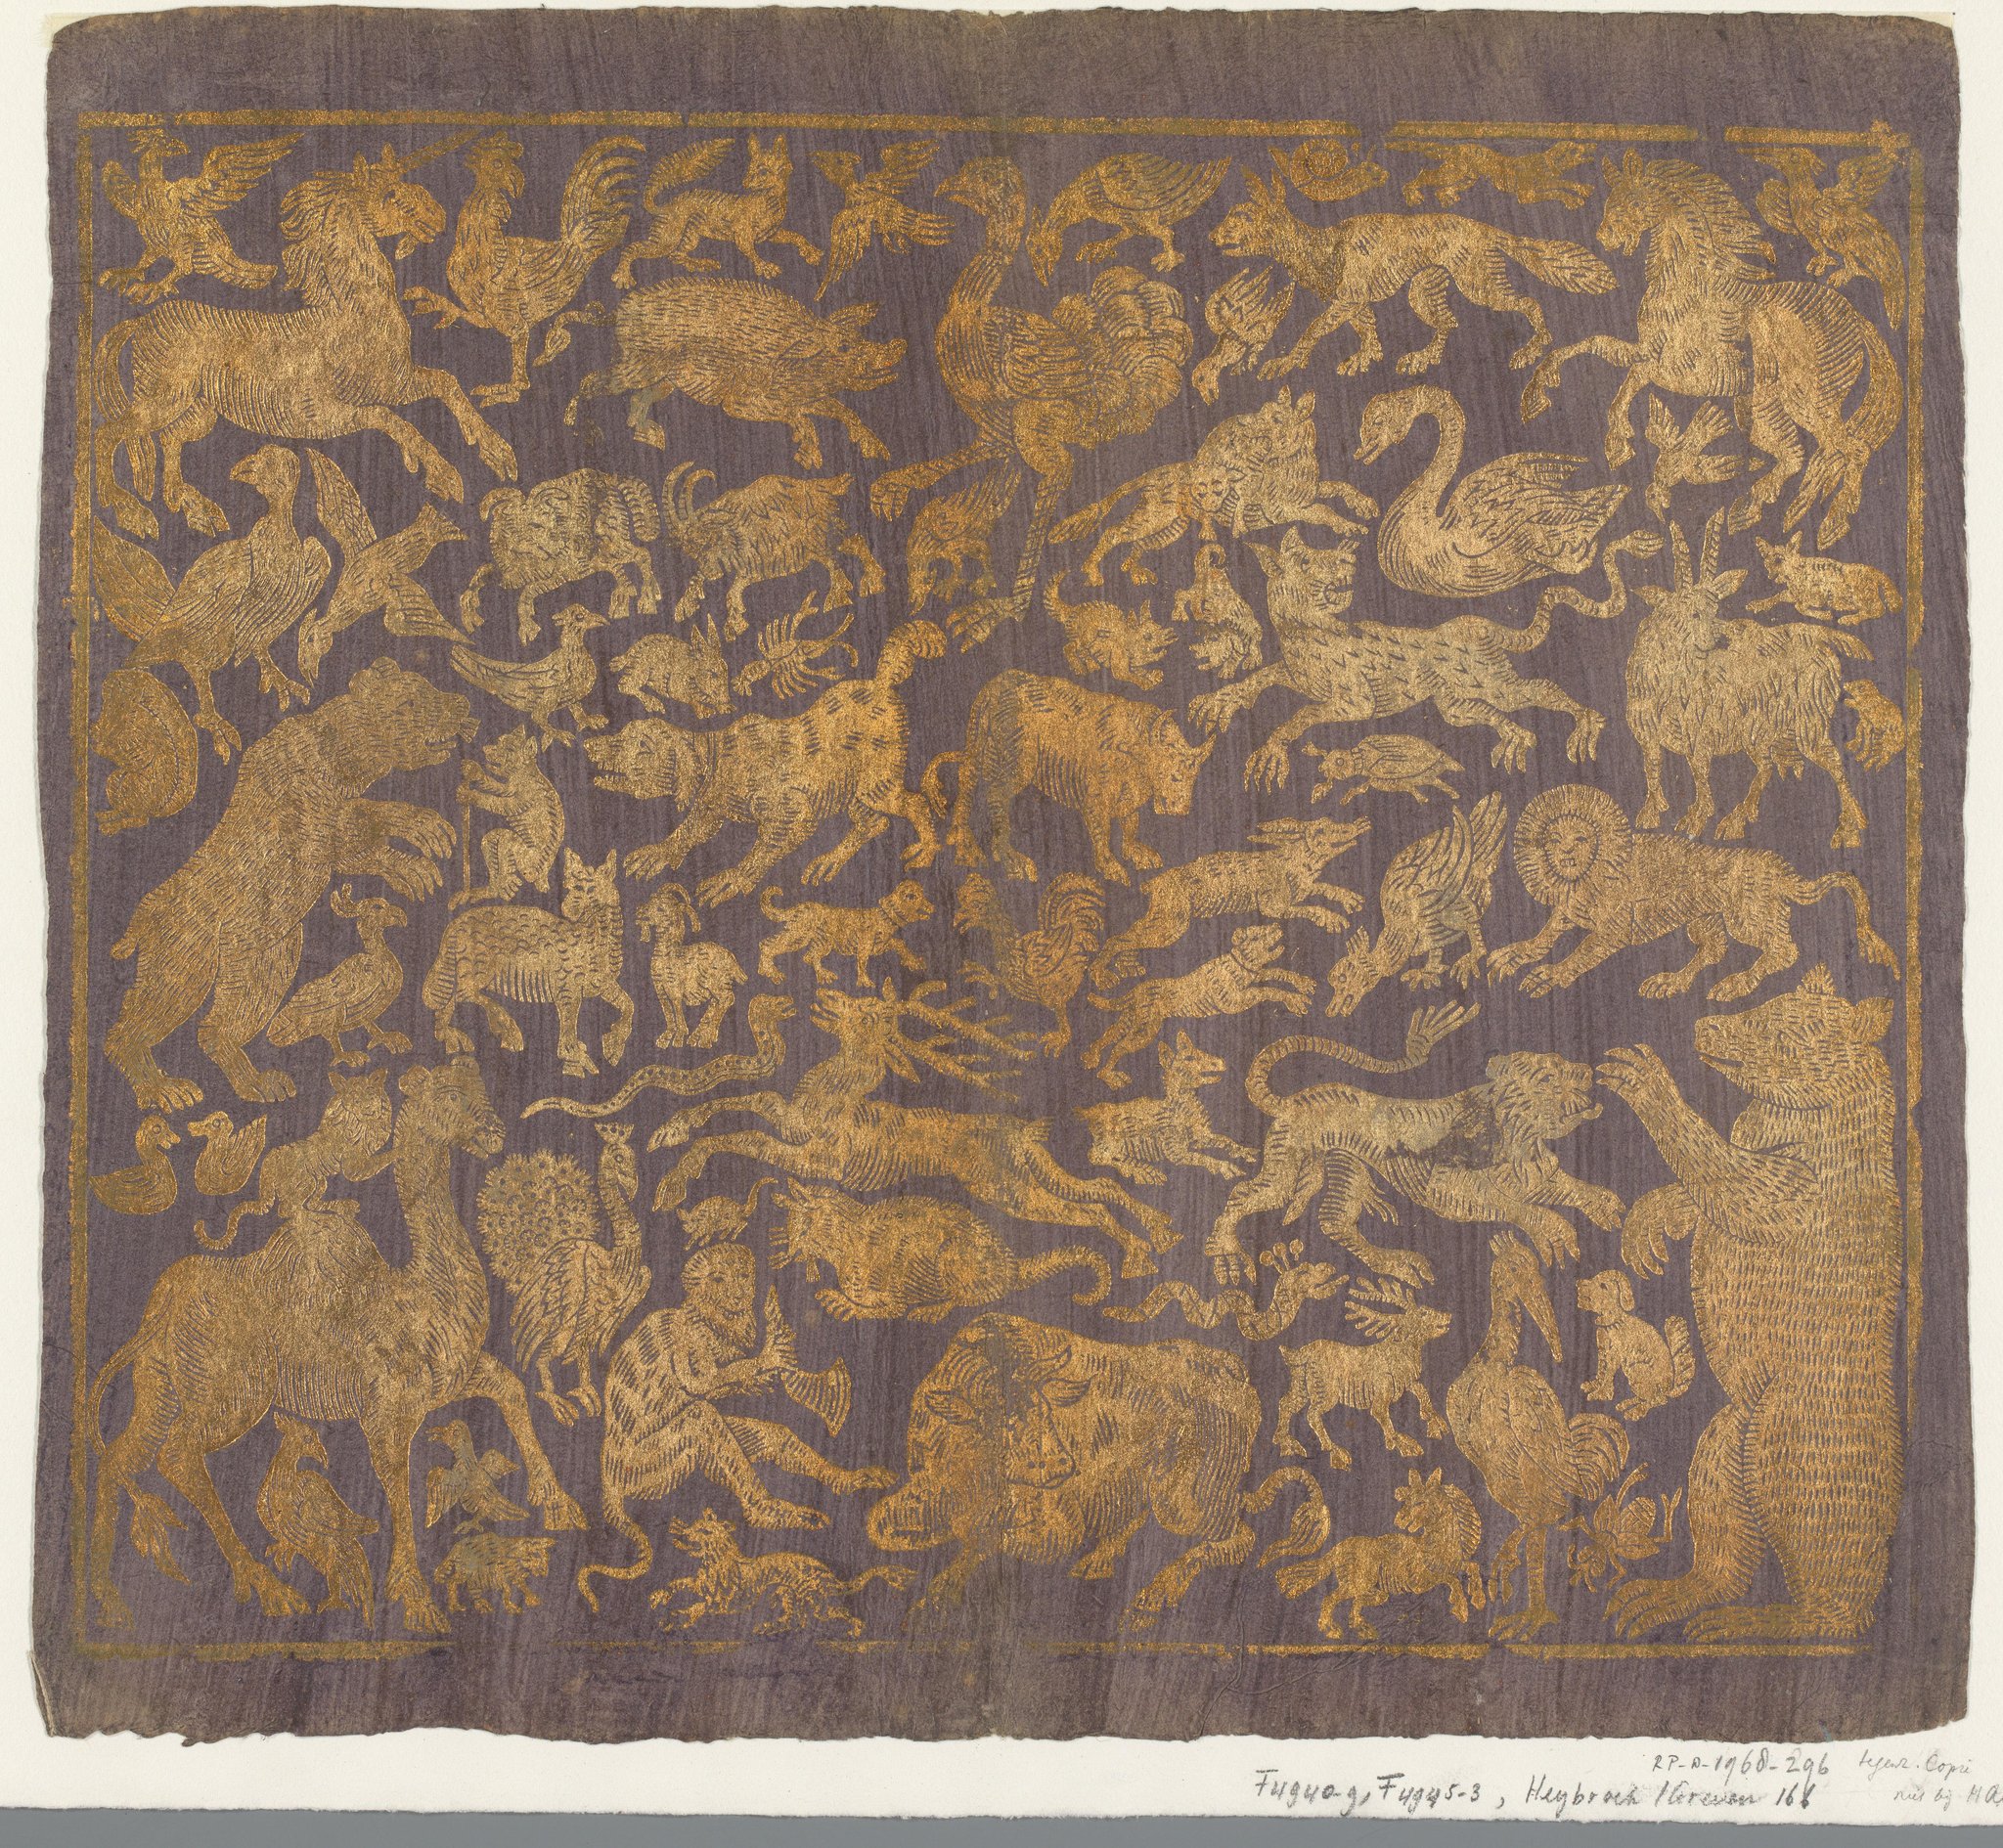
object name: brocade paper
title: Blad met dieren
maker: Anonymous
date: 1750-1820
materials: gold leaf, paint, paper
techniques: relief print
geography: germany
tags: unicorn, animals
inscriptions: collector's mark: Lugt 2228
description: Blad met dieren, linksboven eenhoorn, rechtsboven paard, linksonderstaande dromedaris, rechtsonder beer.